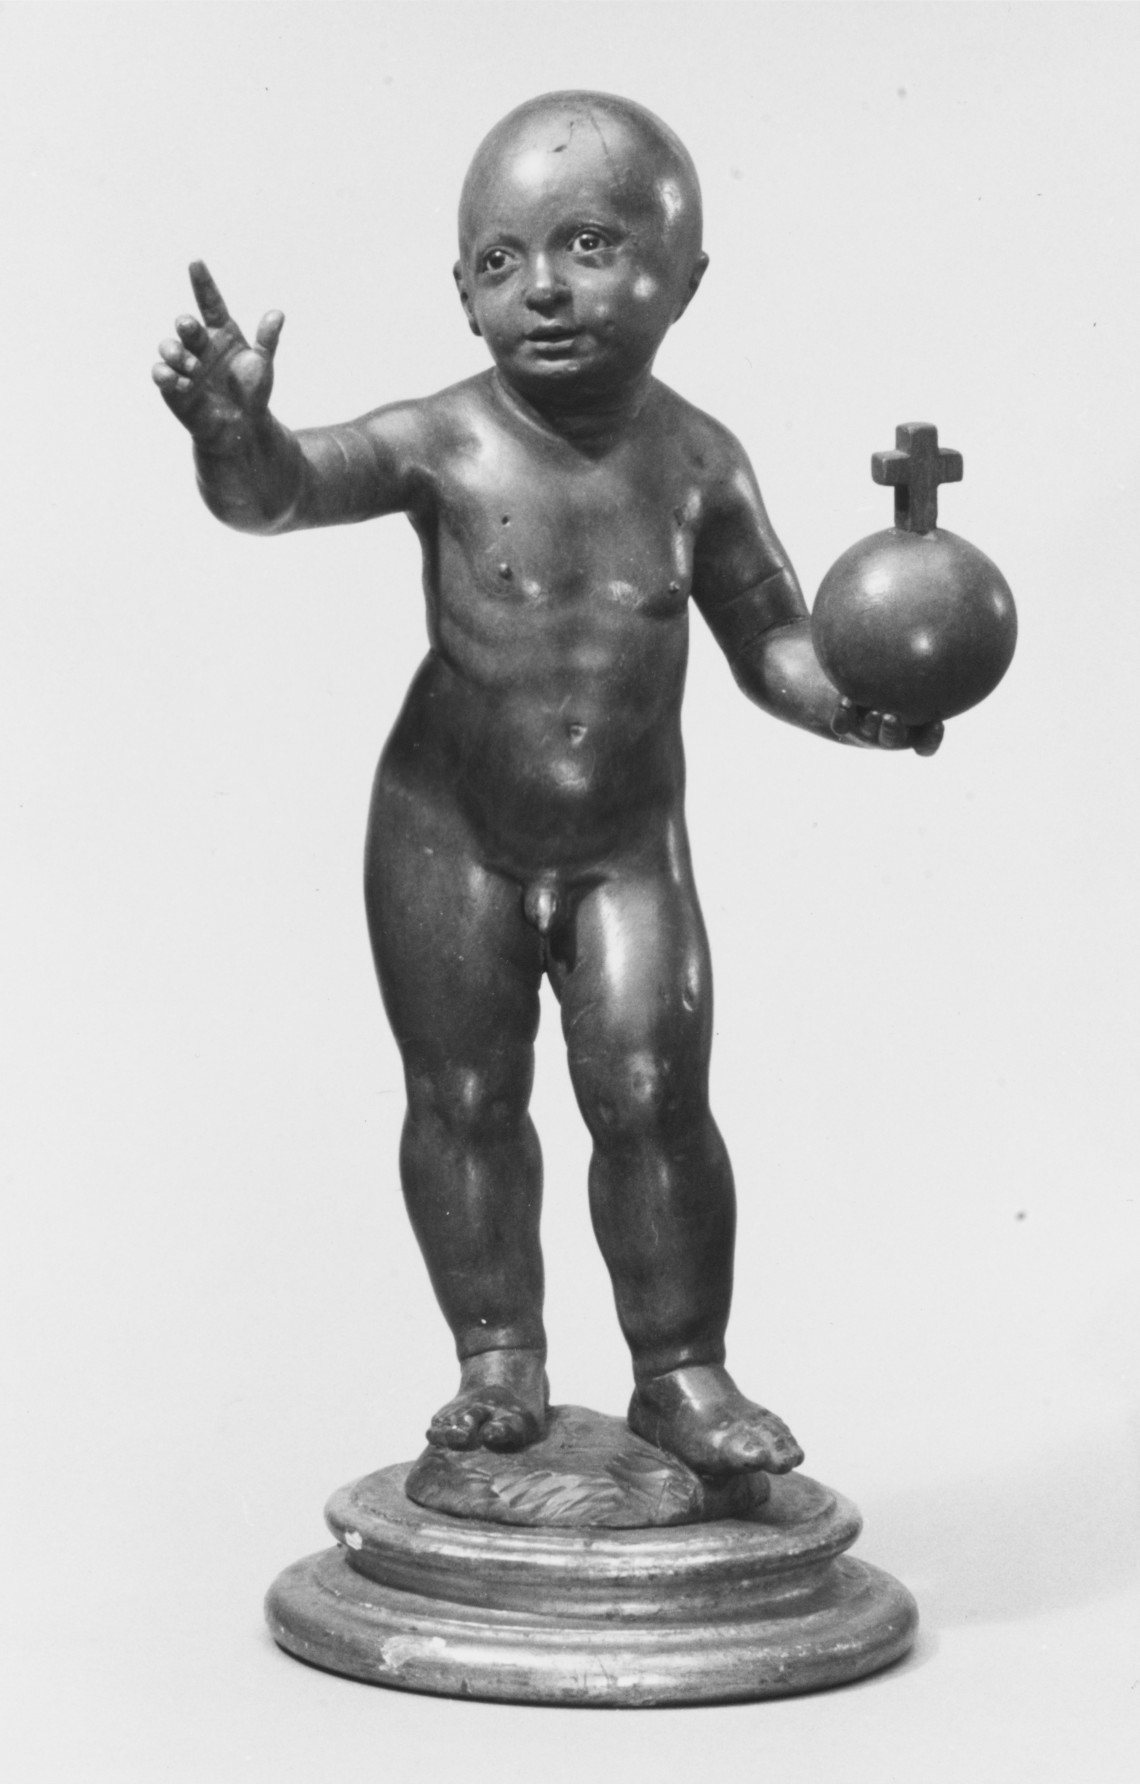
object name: statuette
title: The Christ Child Holding the Orb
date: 1601-1633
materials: wood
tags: christ